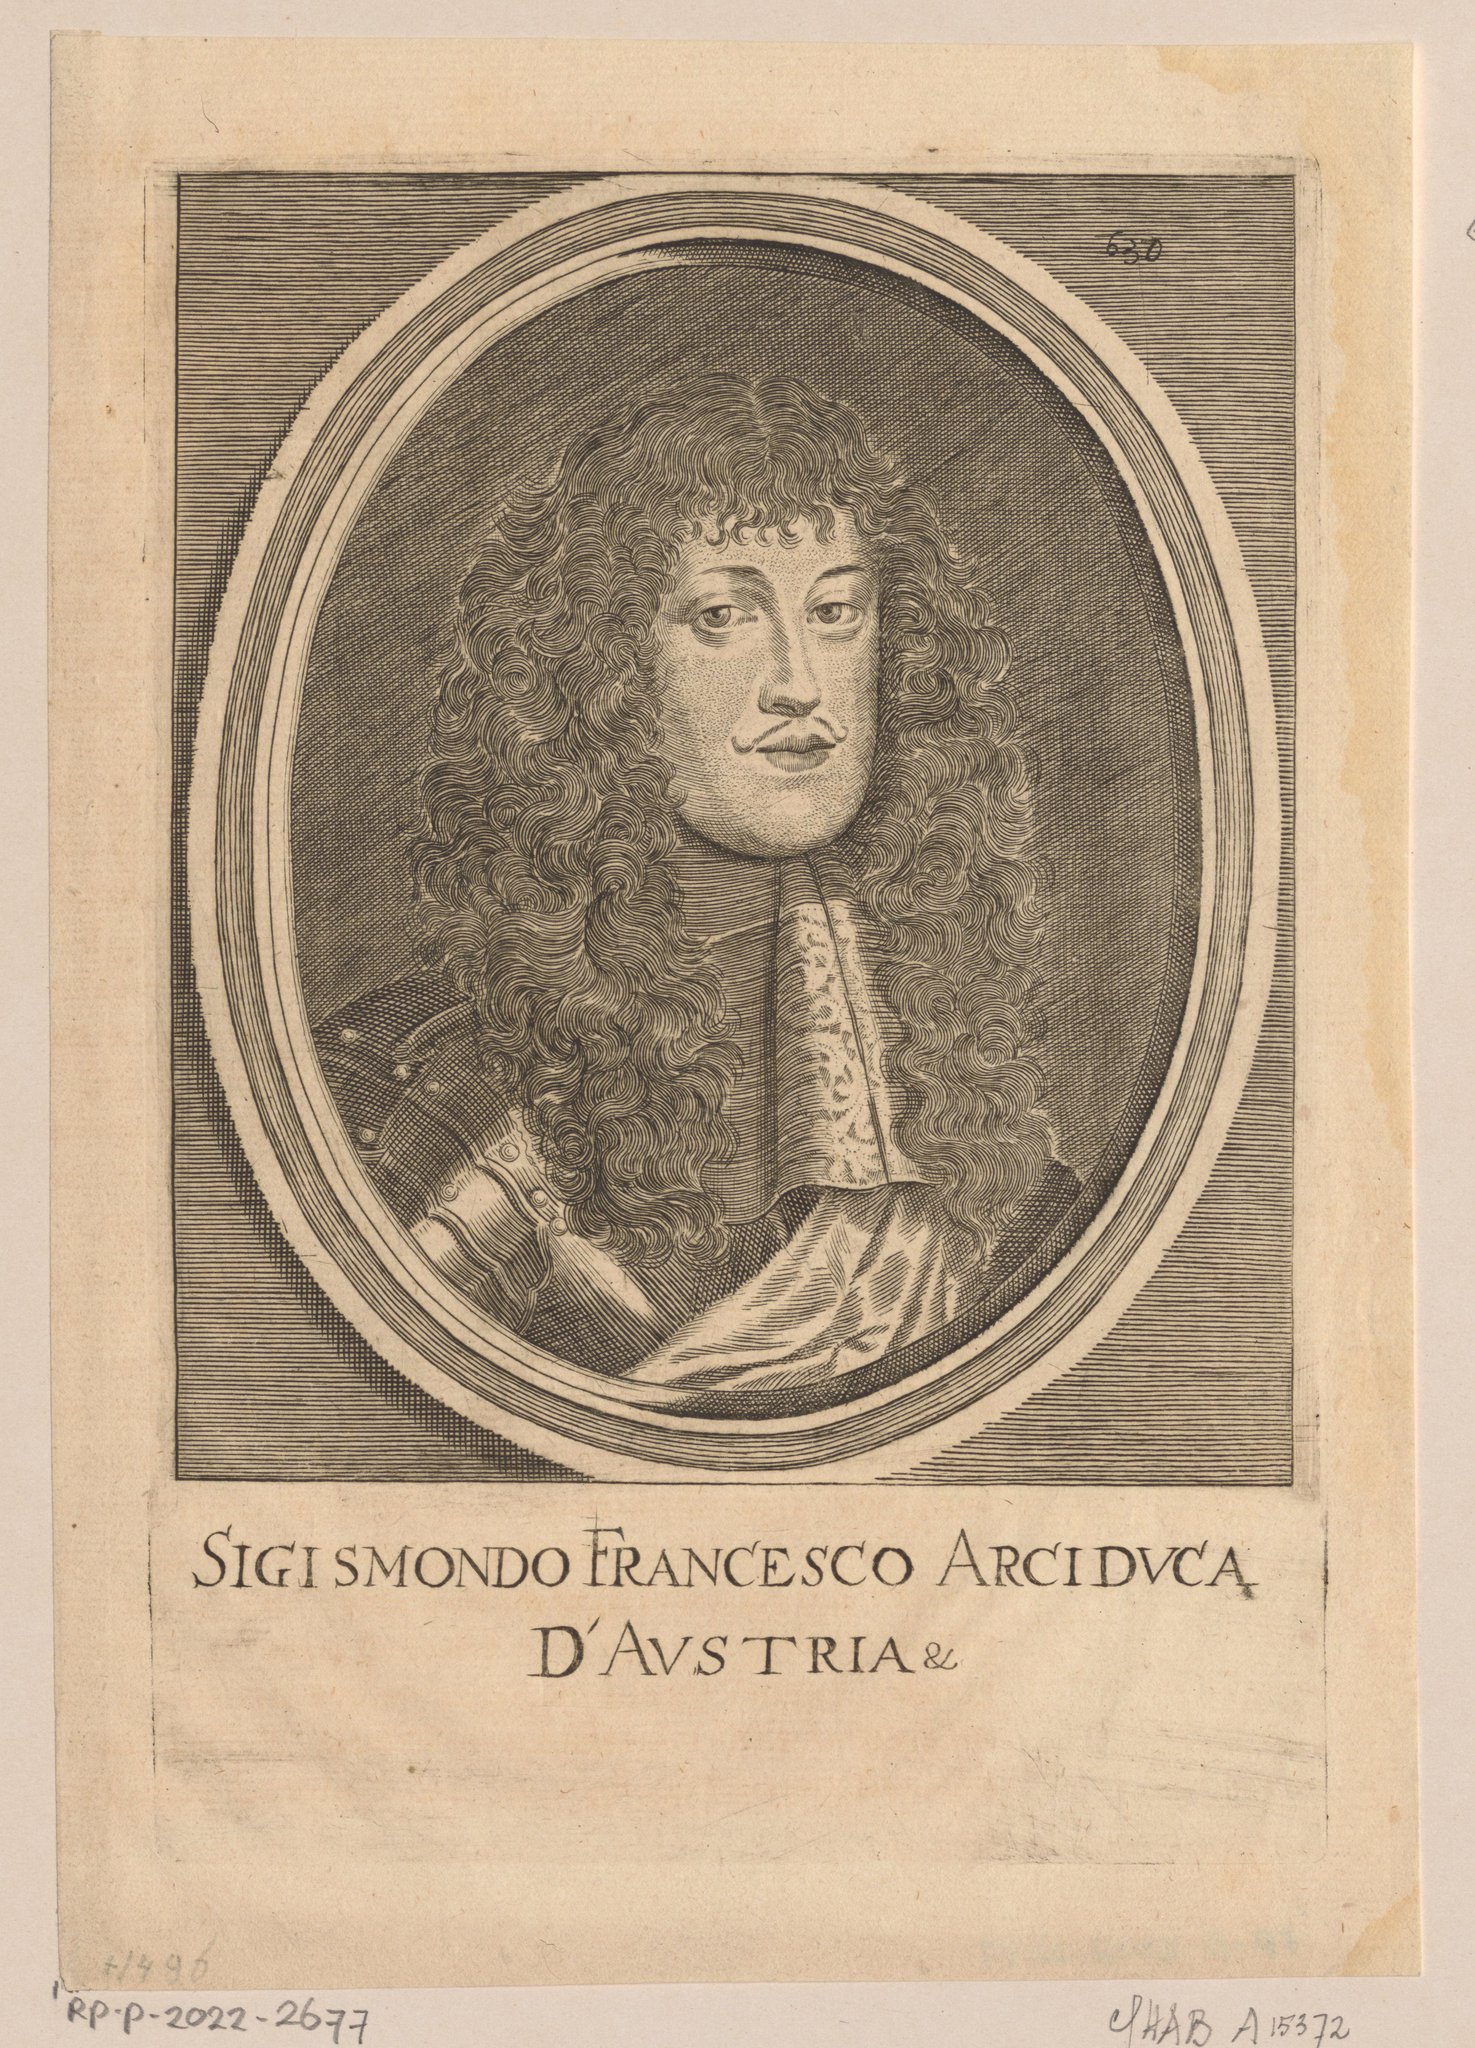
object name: print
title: Portret van Sigismund Franz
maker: Anonymous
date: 1662-1750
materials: paper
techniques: engraving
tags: historical persons, other sovereign (with title)